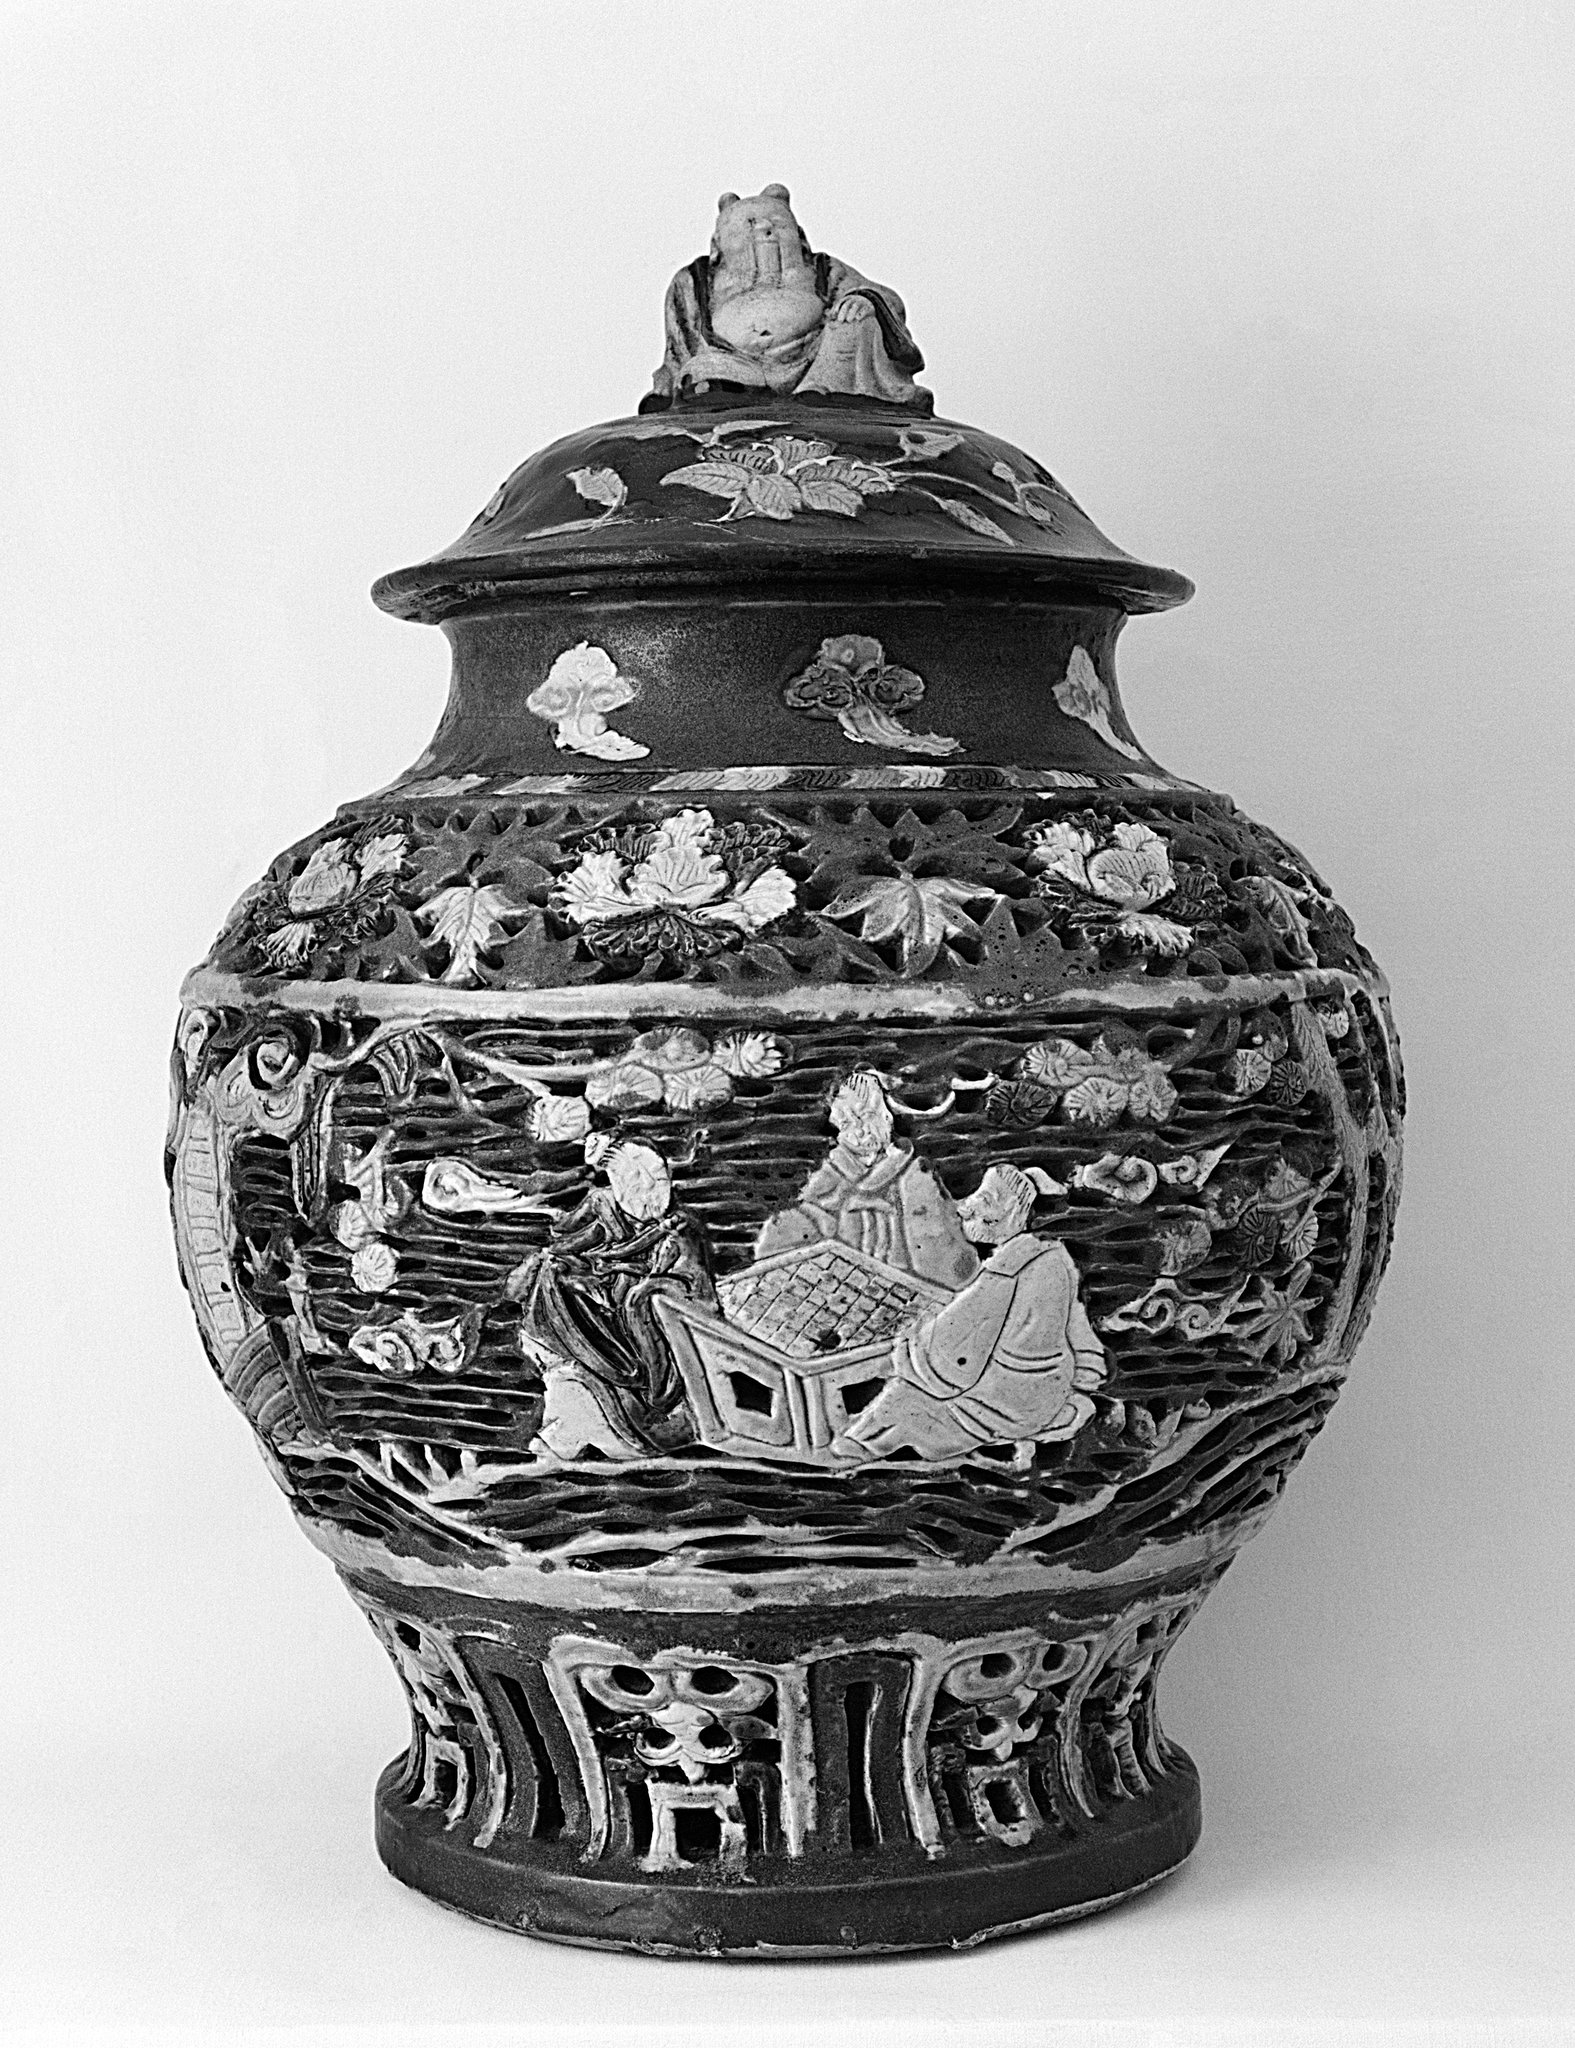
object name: covered jar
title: Covered jar with immortals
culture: chinese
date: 1401-1600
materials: enamel, stoneware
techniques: polychrome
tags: men,tables